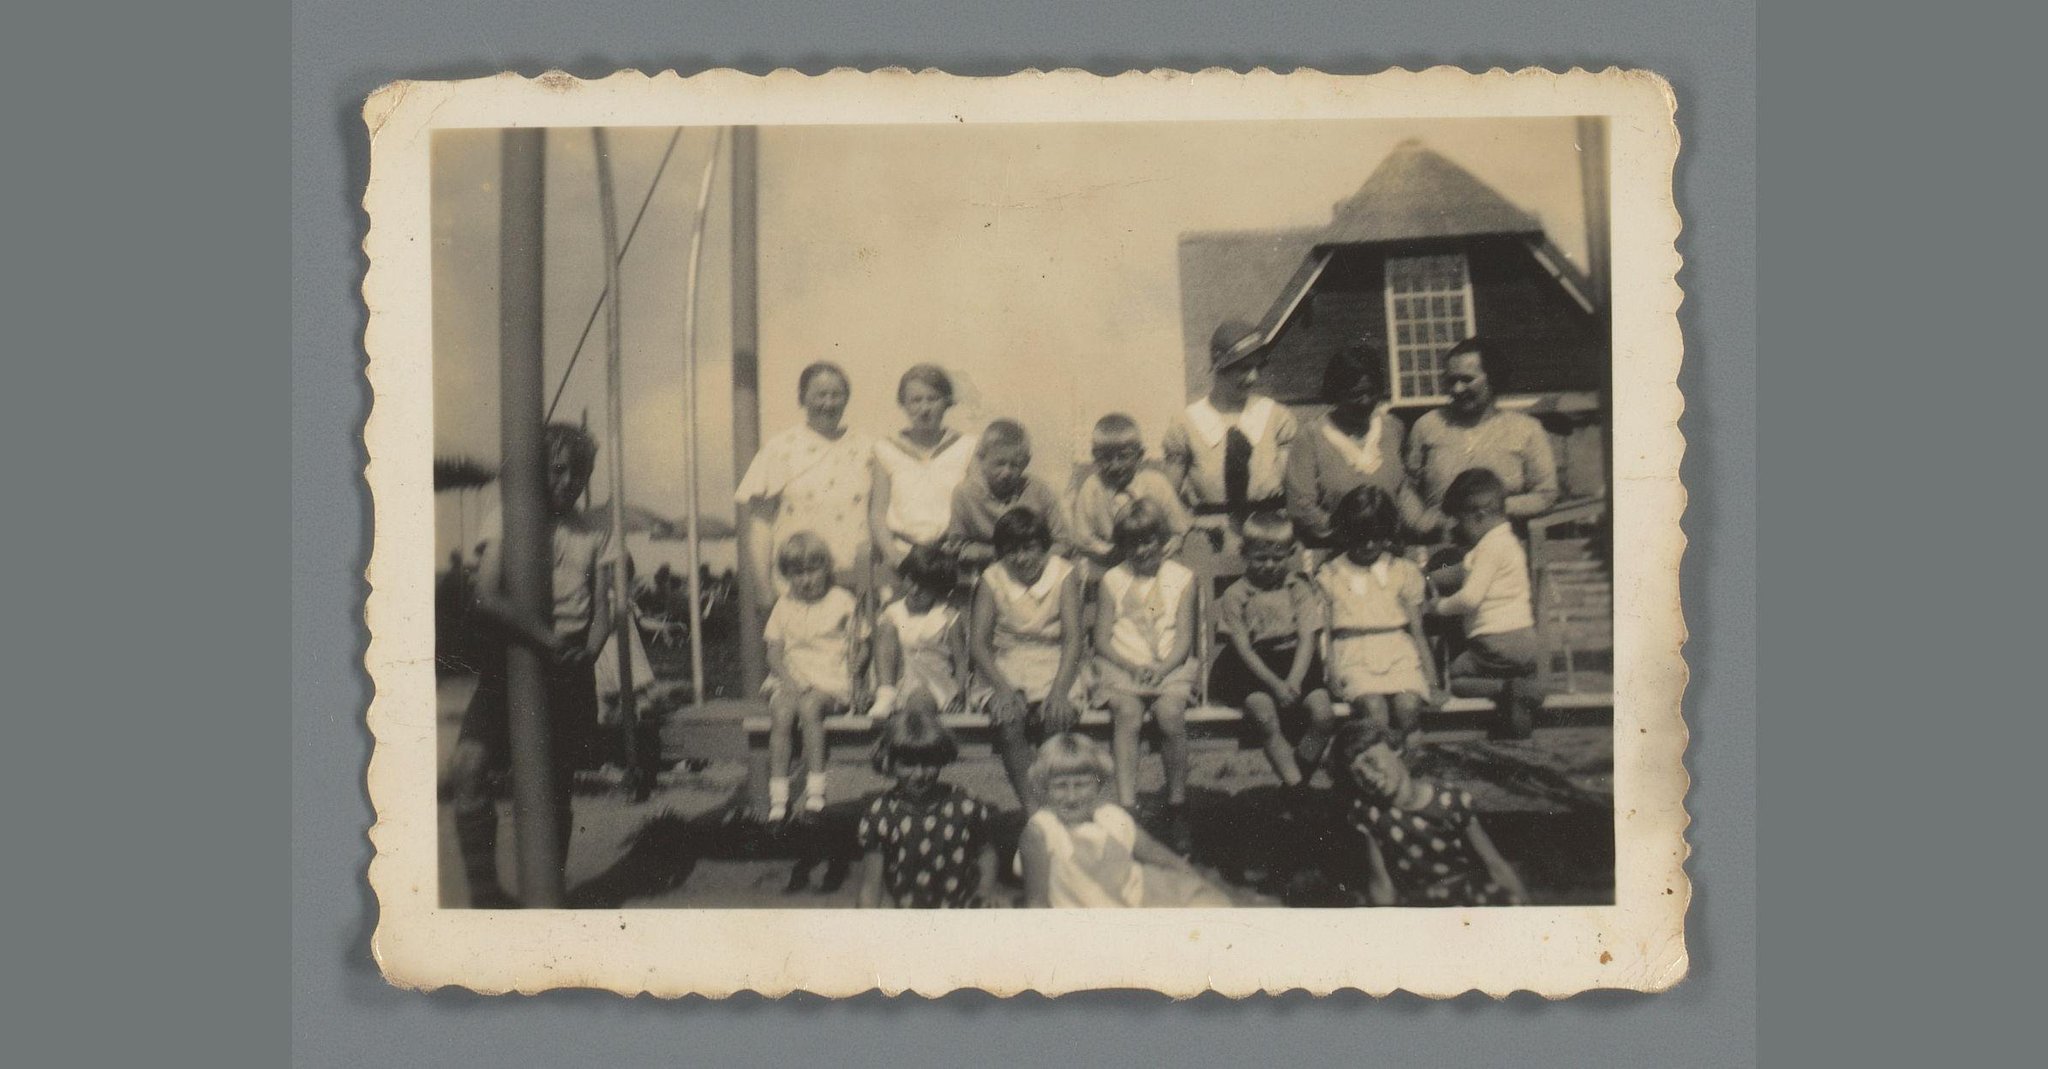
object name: photograph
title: Groepsportret van onbekende kinderen en vrouwen van de familie Mendel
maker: jogchum bleeker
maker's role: fotograaf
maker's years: 1885-1954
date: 1920-1954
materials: paper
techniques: gelatin silver print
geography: leeuwarden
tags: mother and child(ren), woman and child(ren) (family group)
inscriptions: number: ‘23’, stamp: ‘J. Bleeker/ Voorstreek 68 Leeuwarden/ Tel. 6772’, inscription: ‘fam Mendel’